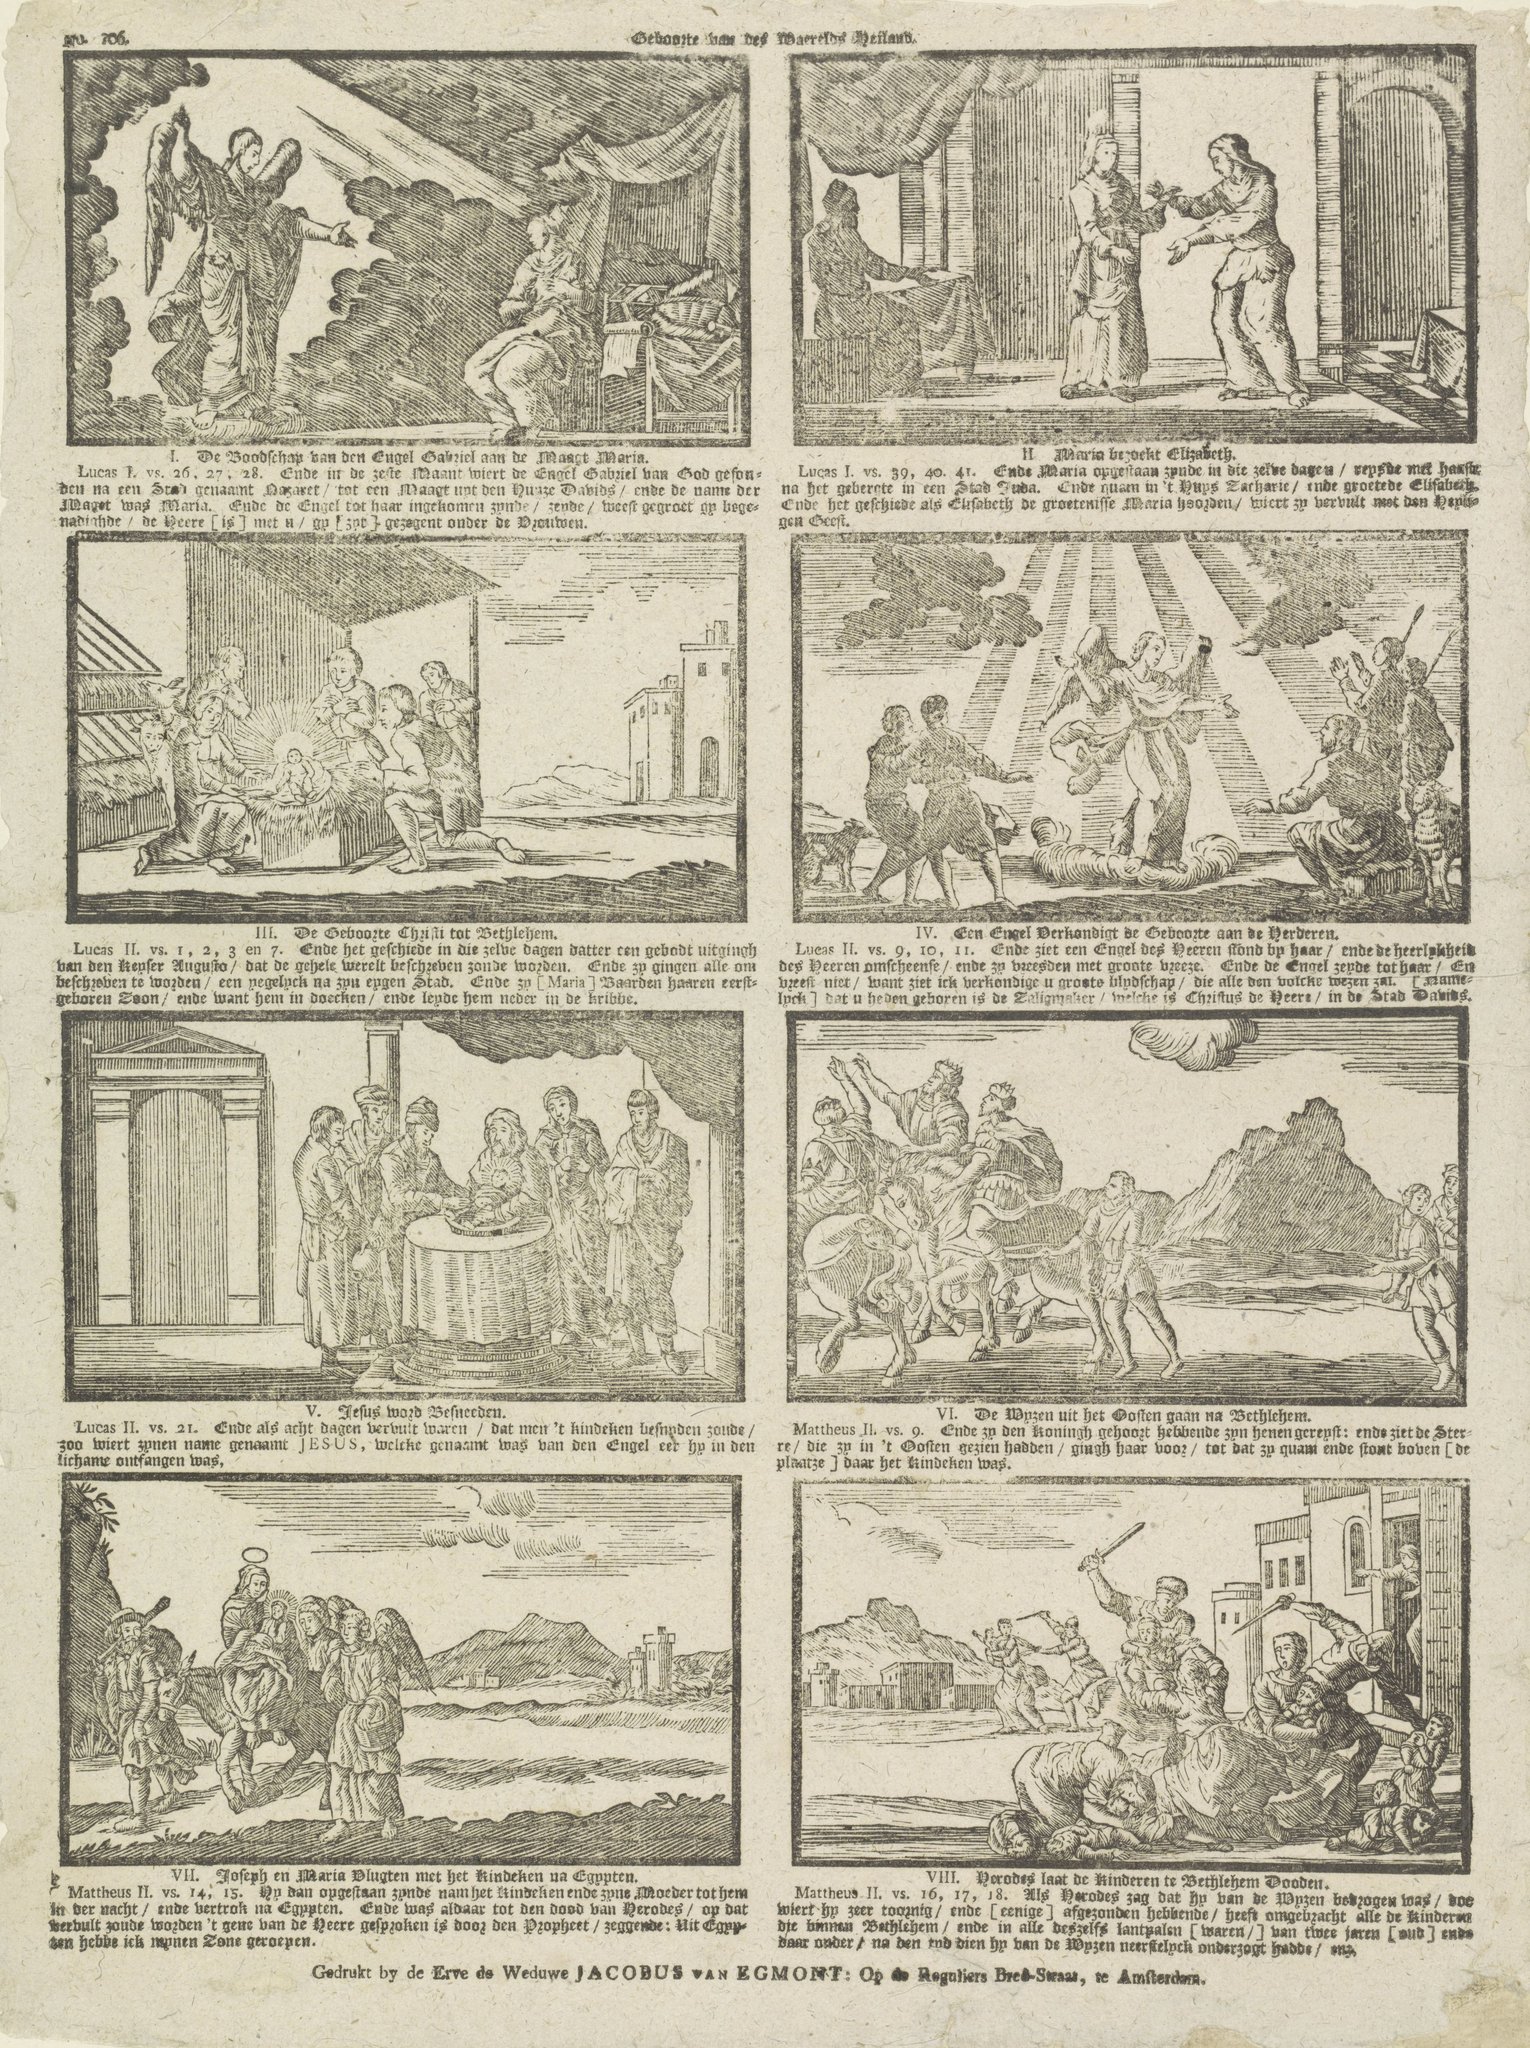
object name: print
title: Geboorte van des waerelds Heiland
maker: Anonymous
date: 1761-1804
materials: paper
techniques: letterpress printing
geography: amsterdam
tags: the flight into egypt: mary, joseph, the child (and sometimes others) on their way; mary usually riding on an ass, series of scenes from the life of christ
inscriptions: collector's mark: Lugt 2760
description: Blad met 8 voorstellingen uit het leven van Christus, waaronder de geboorte van Christus, de besnijdenis en de vlucht naar Egypte. Onder elke voorstelling een bijbehorende Bijbeltekst. Genummerd linksboven: No. 106.